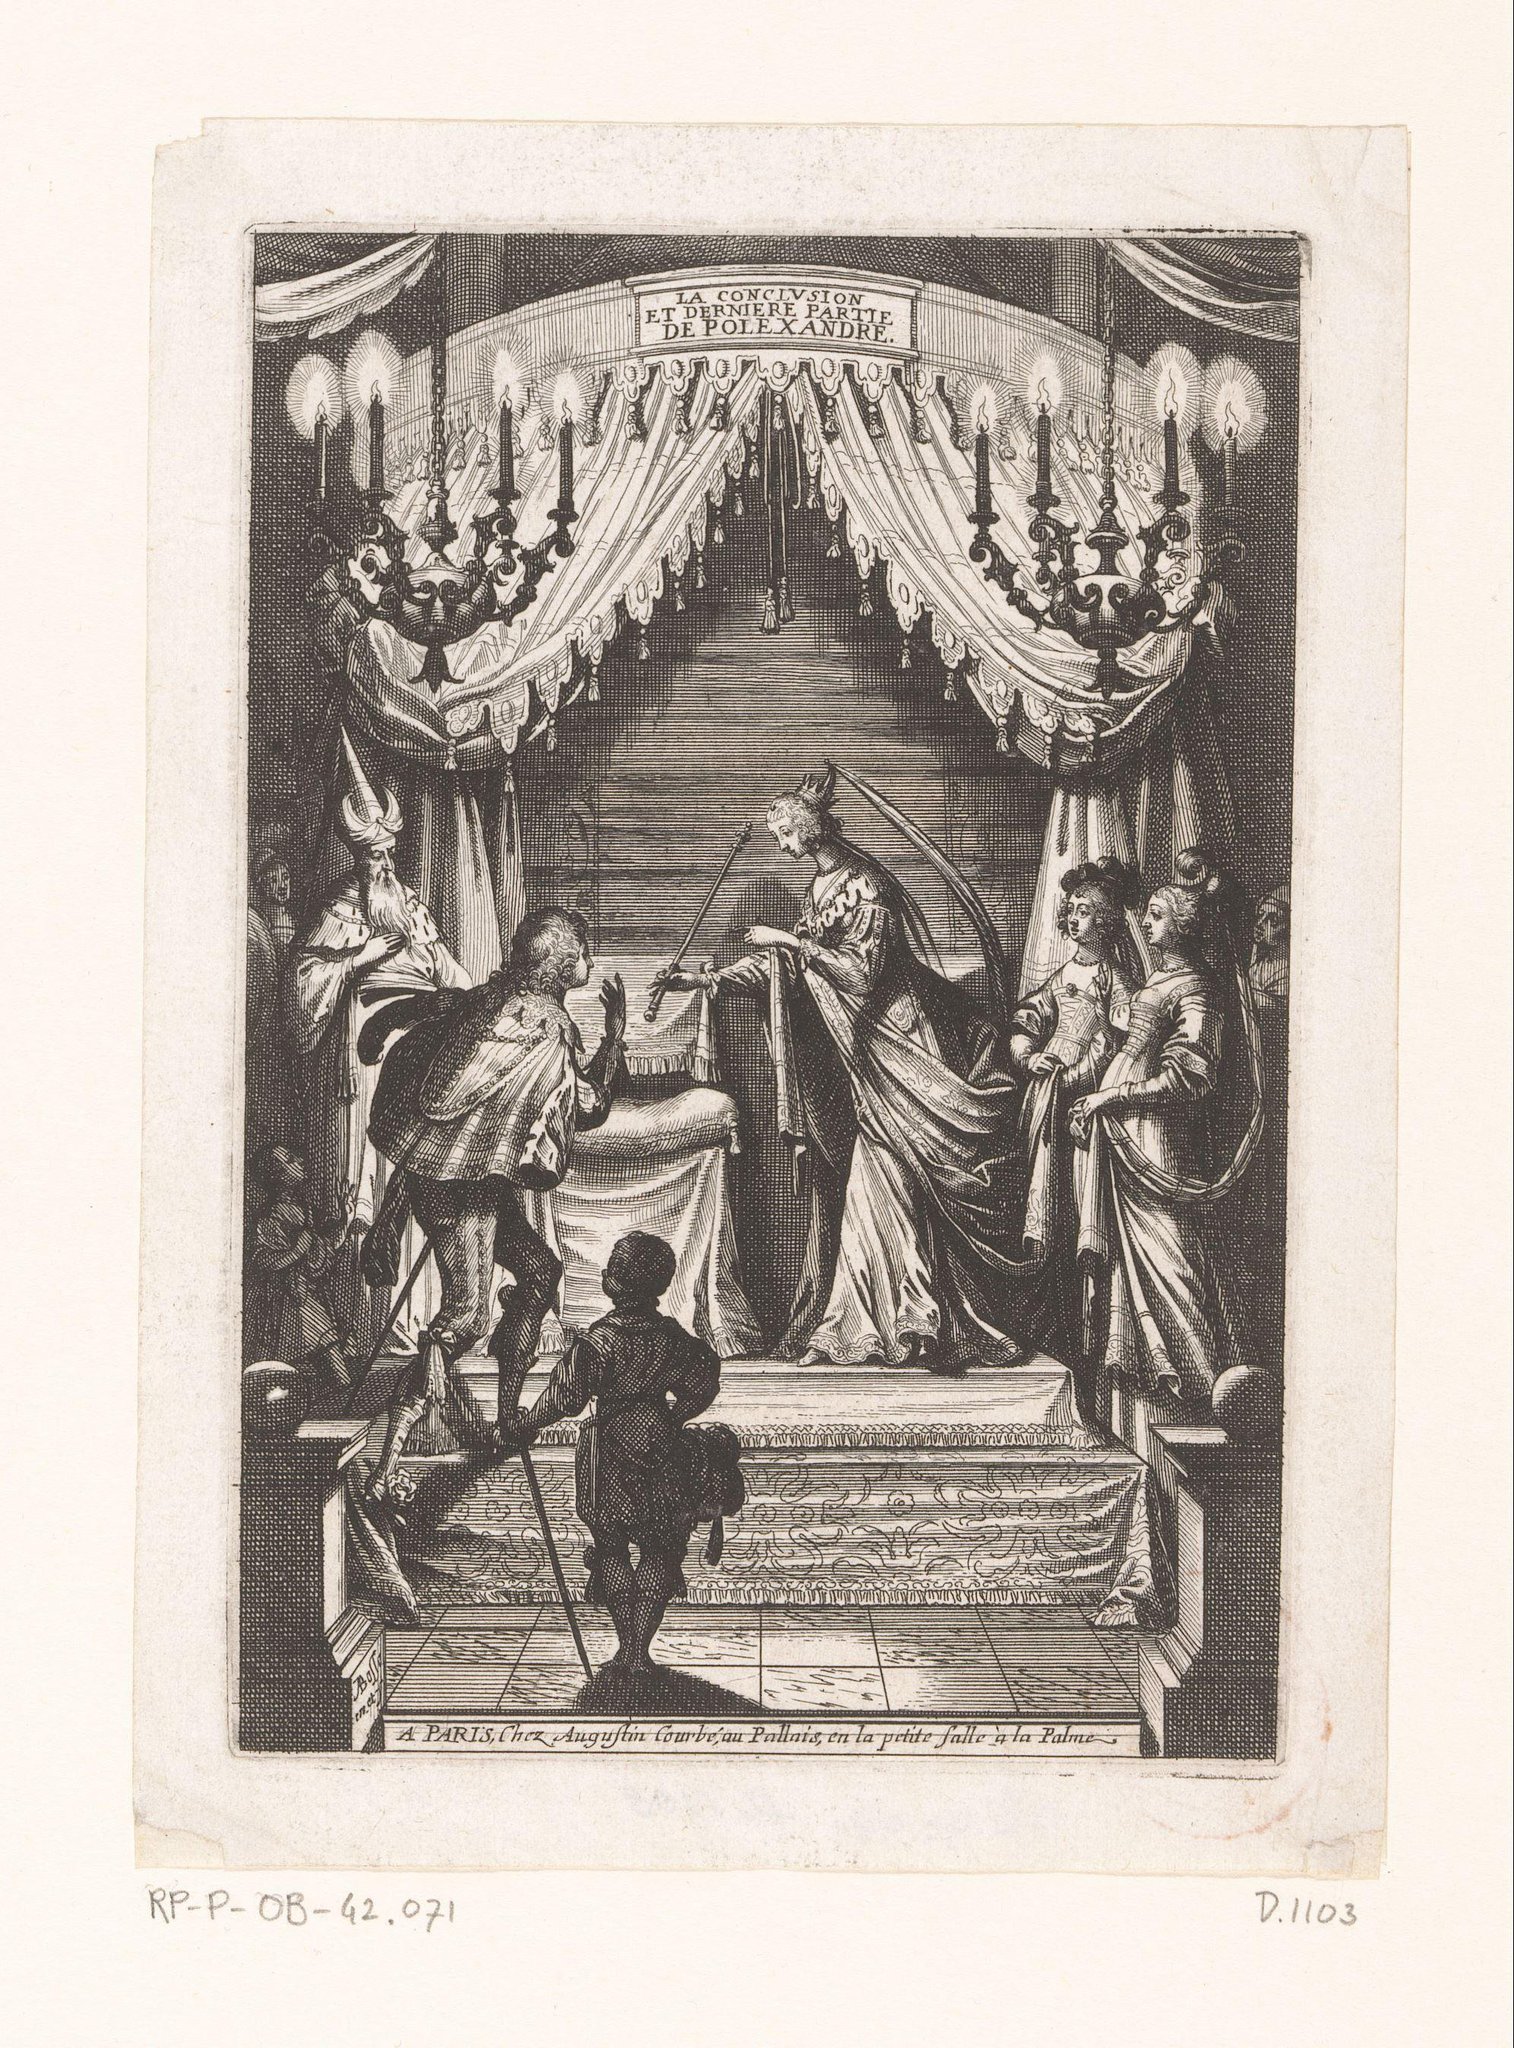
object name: print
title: Koningin overhandigt een scepter aan Polexandre onder een baldakijn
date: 1637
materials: paper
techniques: engraving, etching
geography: paris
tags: canopy, baldachin, sceptre, staff (symbol of sovereignty), queen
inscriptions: collector's mark: Lugt 240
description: Titelpagina voor: Gomberville, Marin le Roy de. La conclusion et dernière partie de Polexandre. Parijs: Courbé, Augustin, 1637.